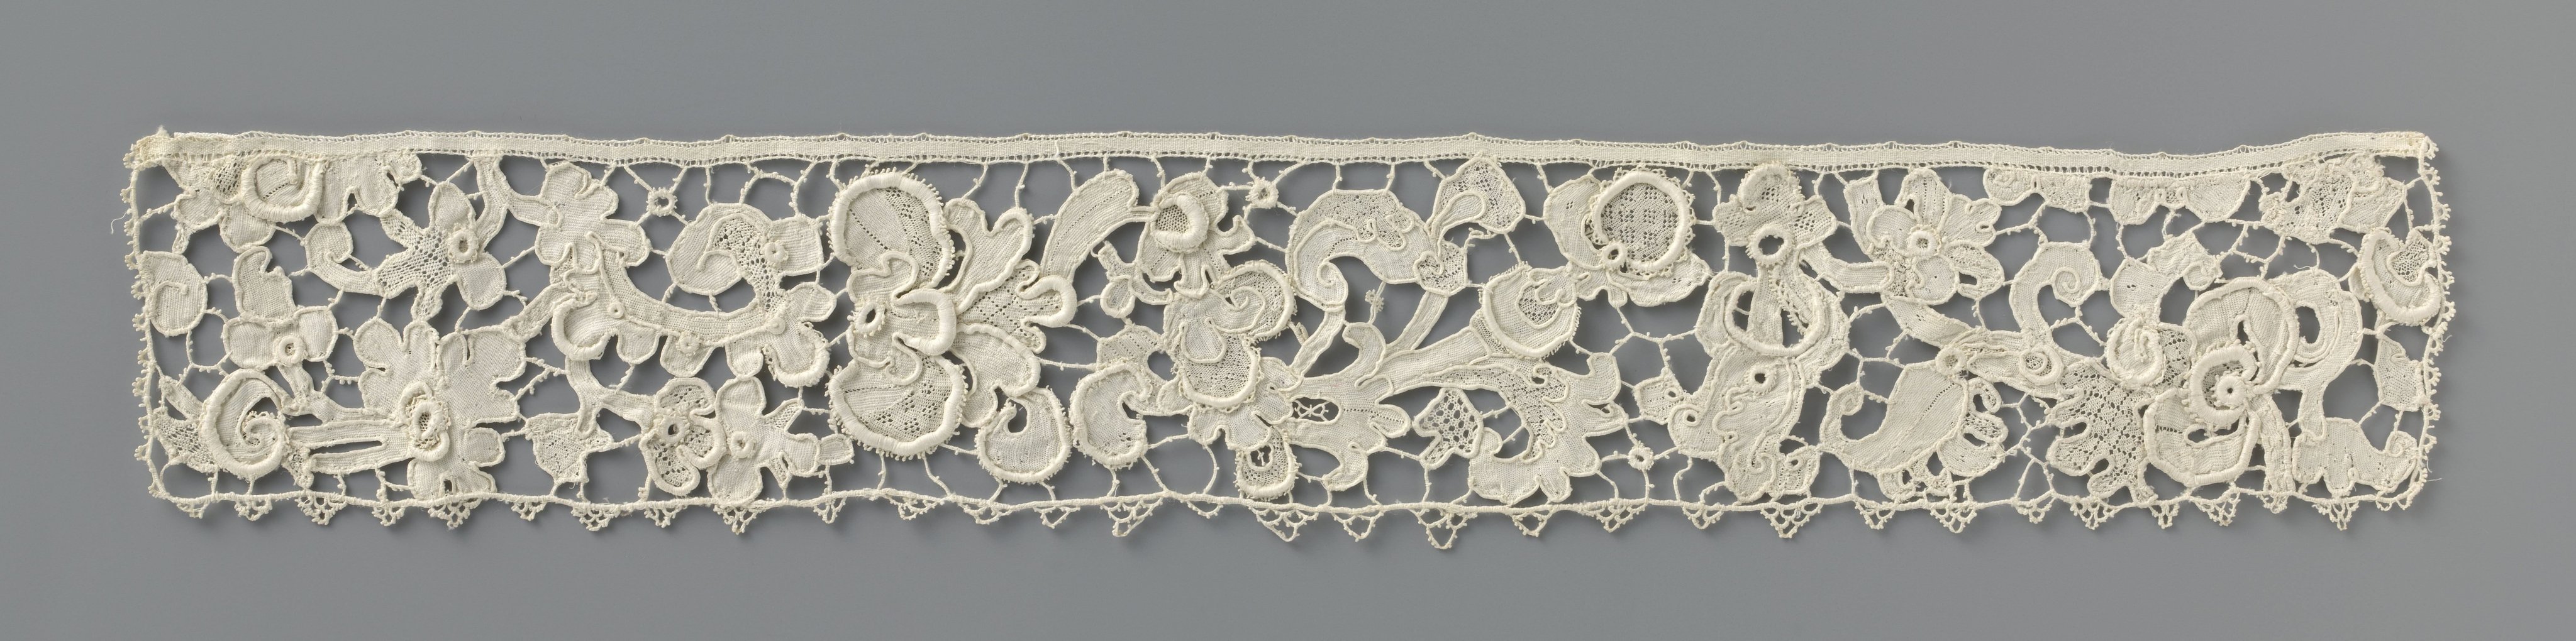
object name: collar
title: Kraag van naaldkant met niet gebonden ranken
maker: Anonymous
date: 1675-1699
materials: linen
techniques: embroidery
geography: venice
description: Kraag van naturelkleurige naaldkant: Venetiaanse reliëfkant. Smal, rechthoekig model. Willekeurig verspreide grote en kleine palmetbloemen en slechts enkele stengels met bladvoluten tekenen zich af tegen een open spijlengrond. Langs de buitenkant is een rij driehoekige boogjes aangebracht, aan de twee uiteinden een parellijstje.